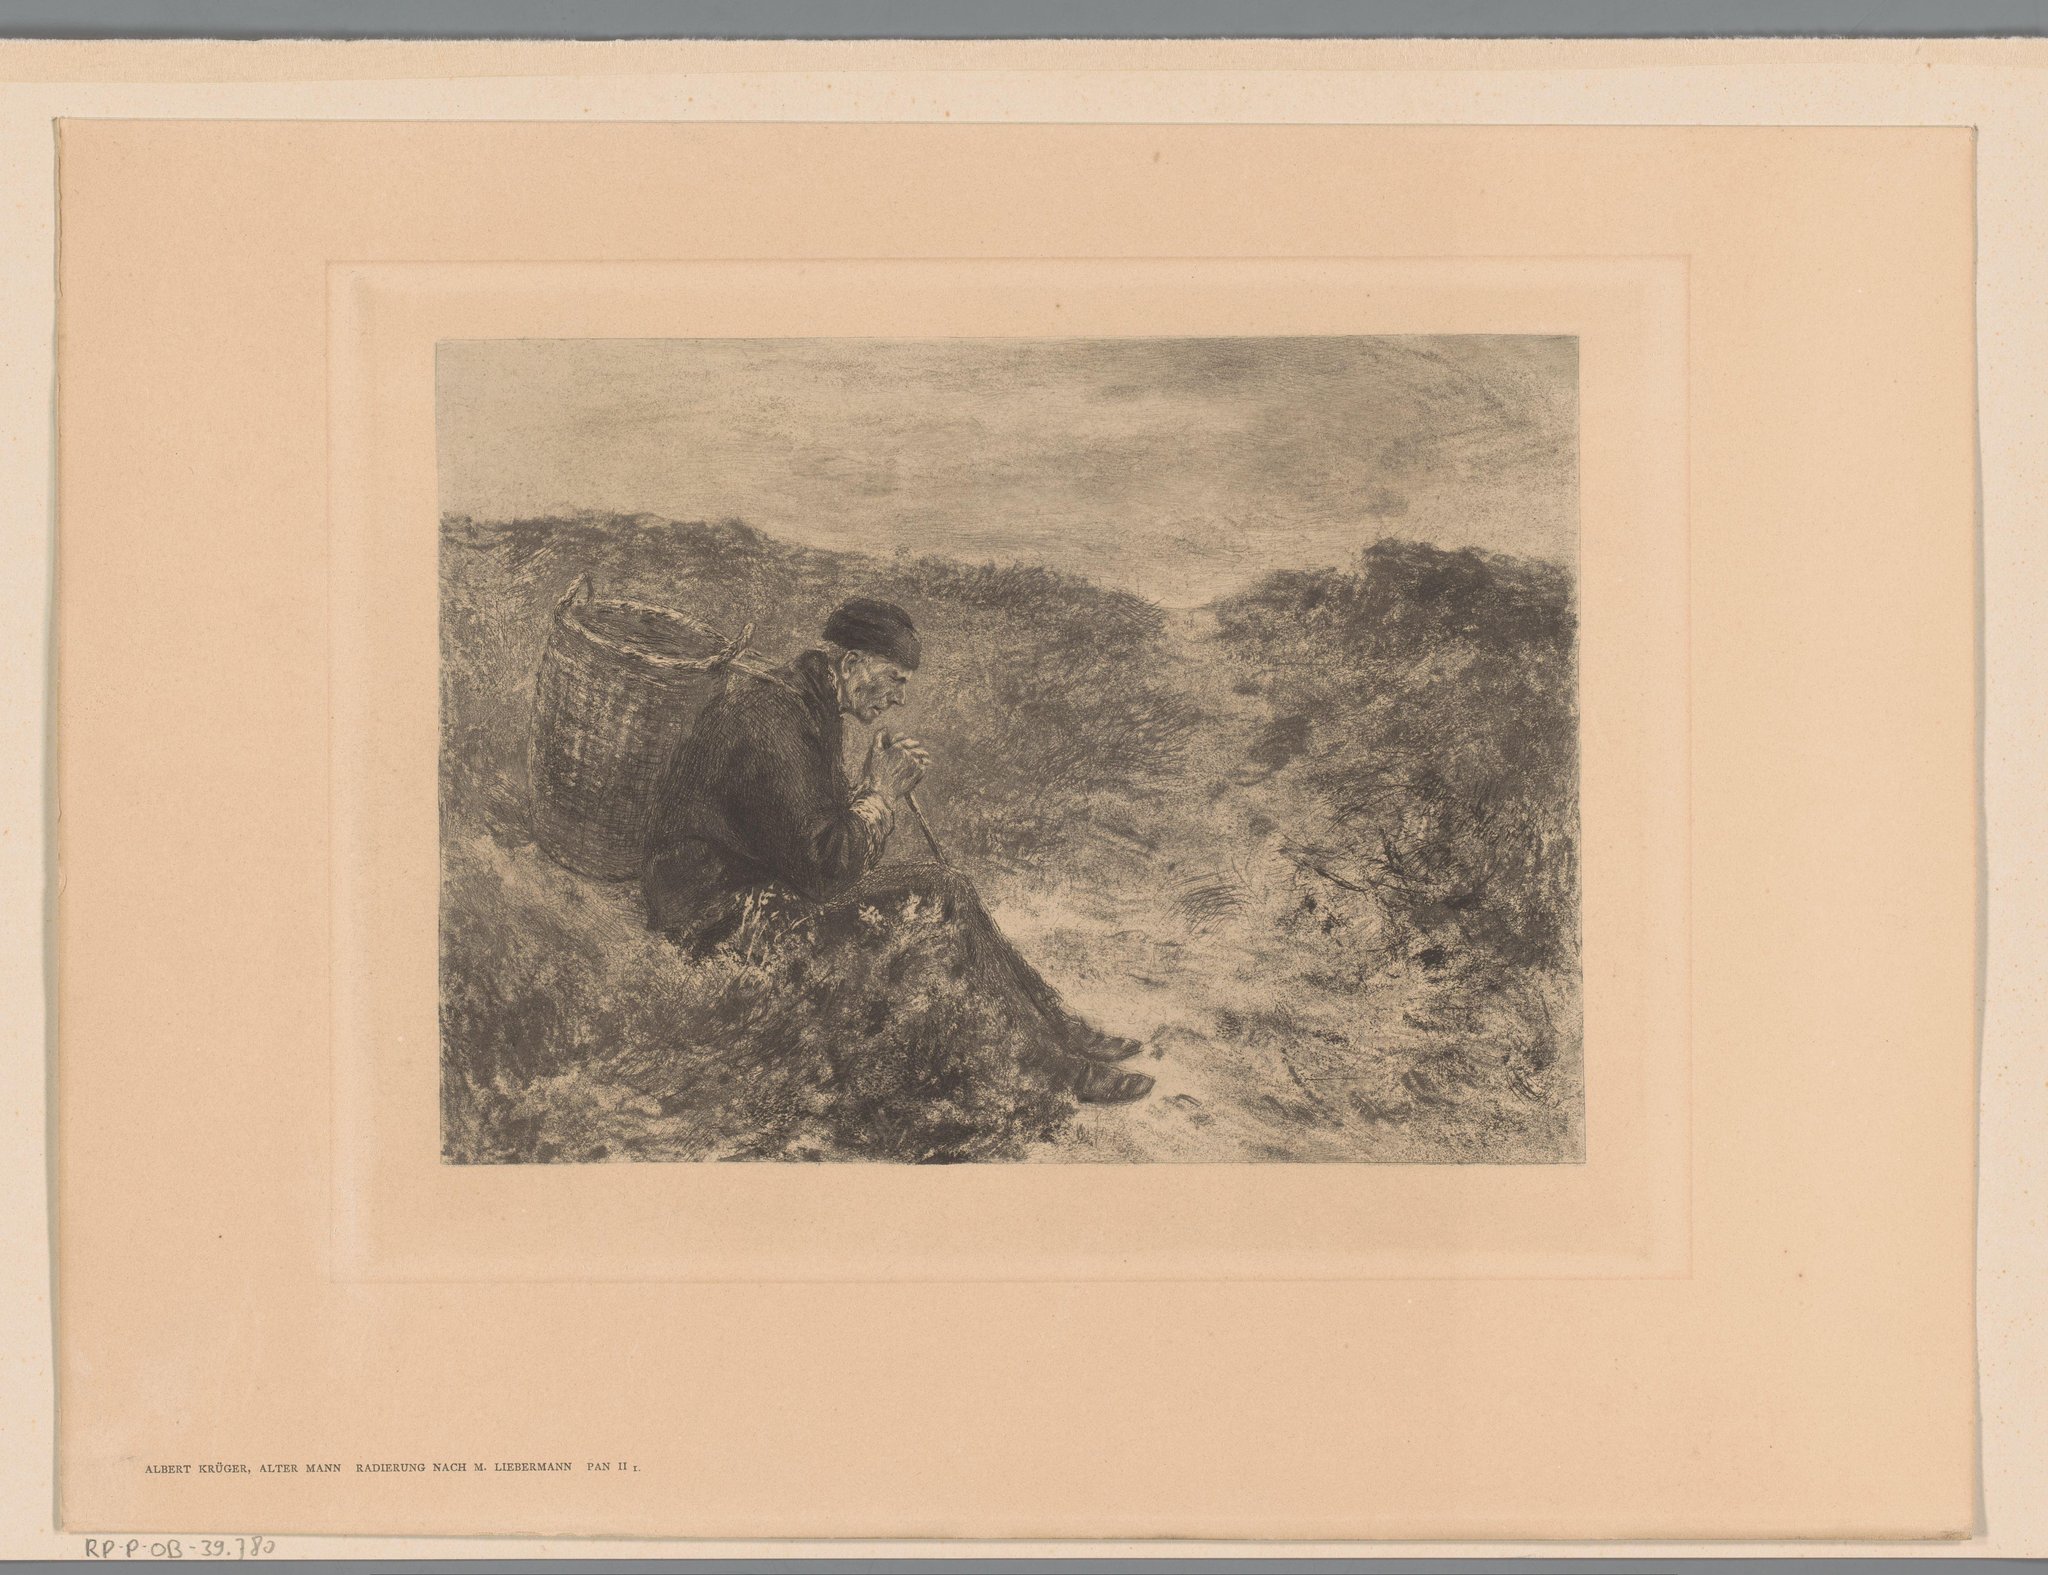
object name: print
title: Alter man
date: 1897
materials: paper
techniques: drypoint, etching, intaglio, soft ground etching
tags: sitting figure, old man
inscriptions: collector's mark: Lugt 2228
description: Prent is uitgeven in het tijdschrift 'Pan', 1896-1897, deel 2.